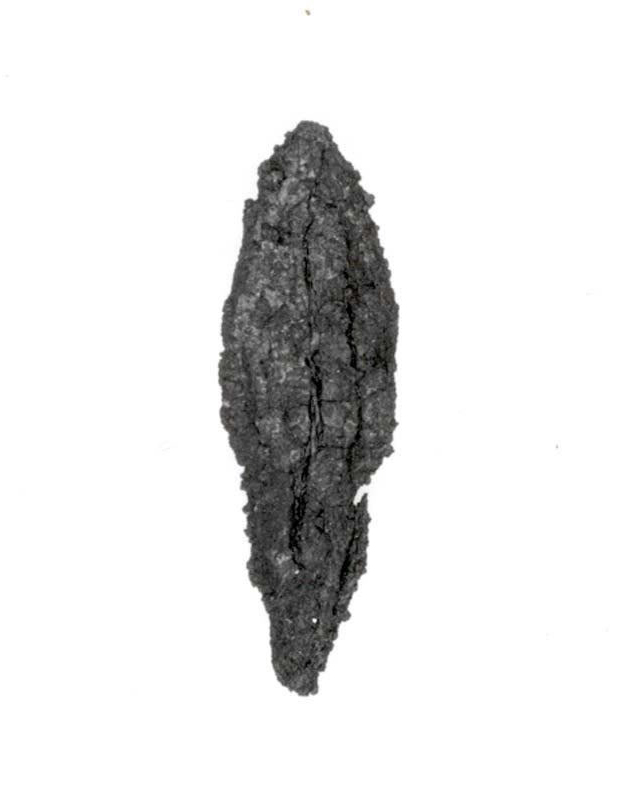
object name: arrowhead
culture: assyrian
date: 612 BCE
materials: iron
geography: mesopotamia